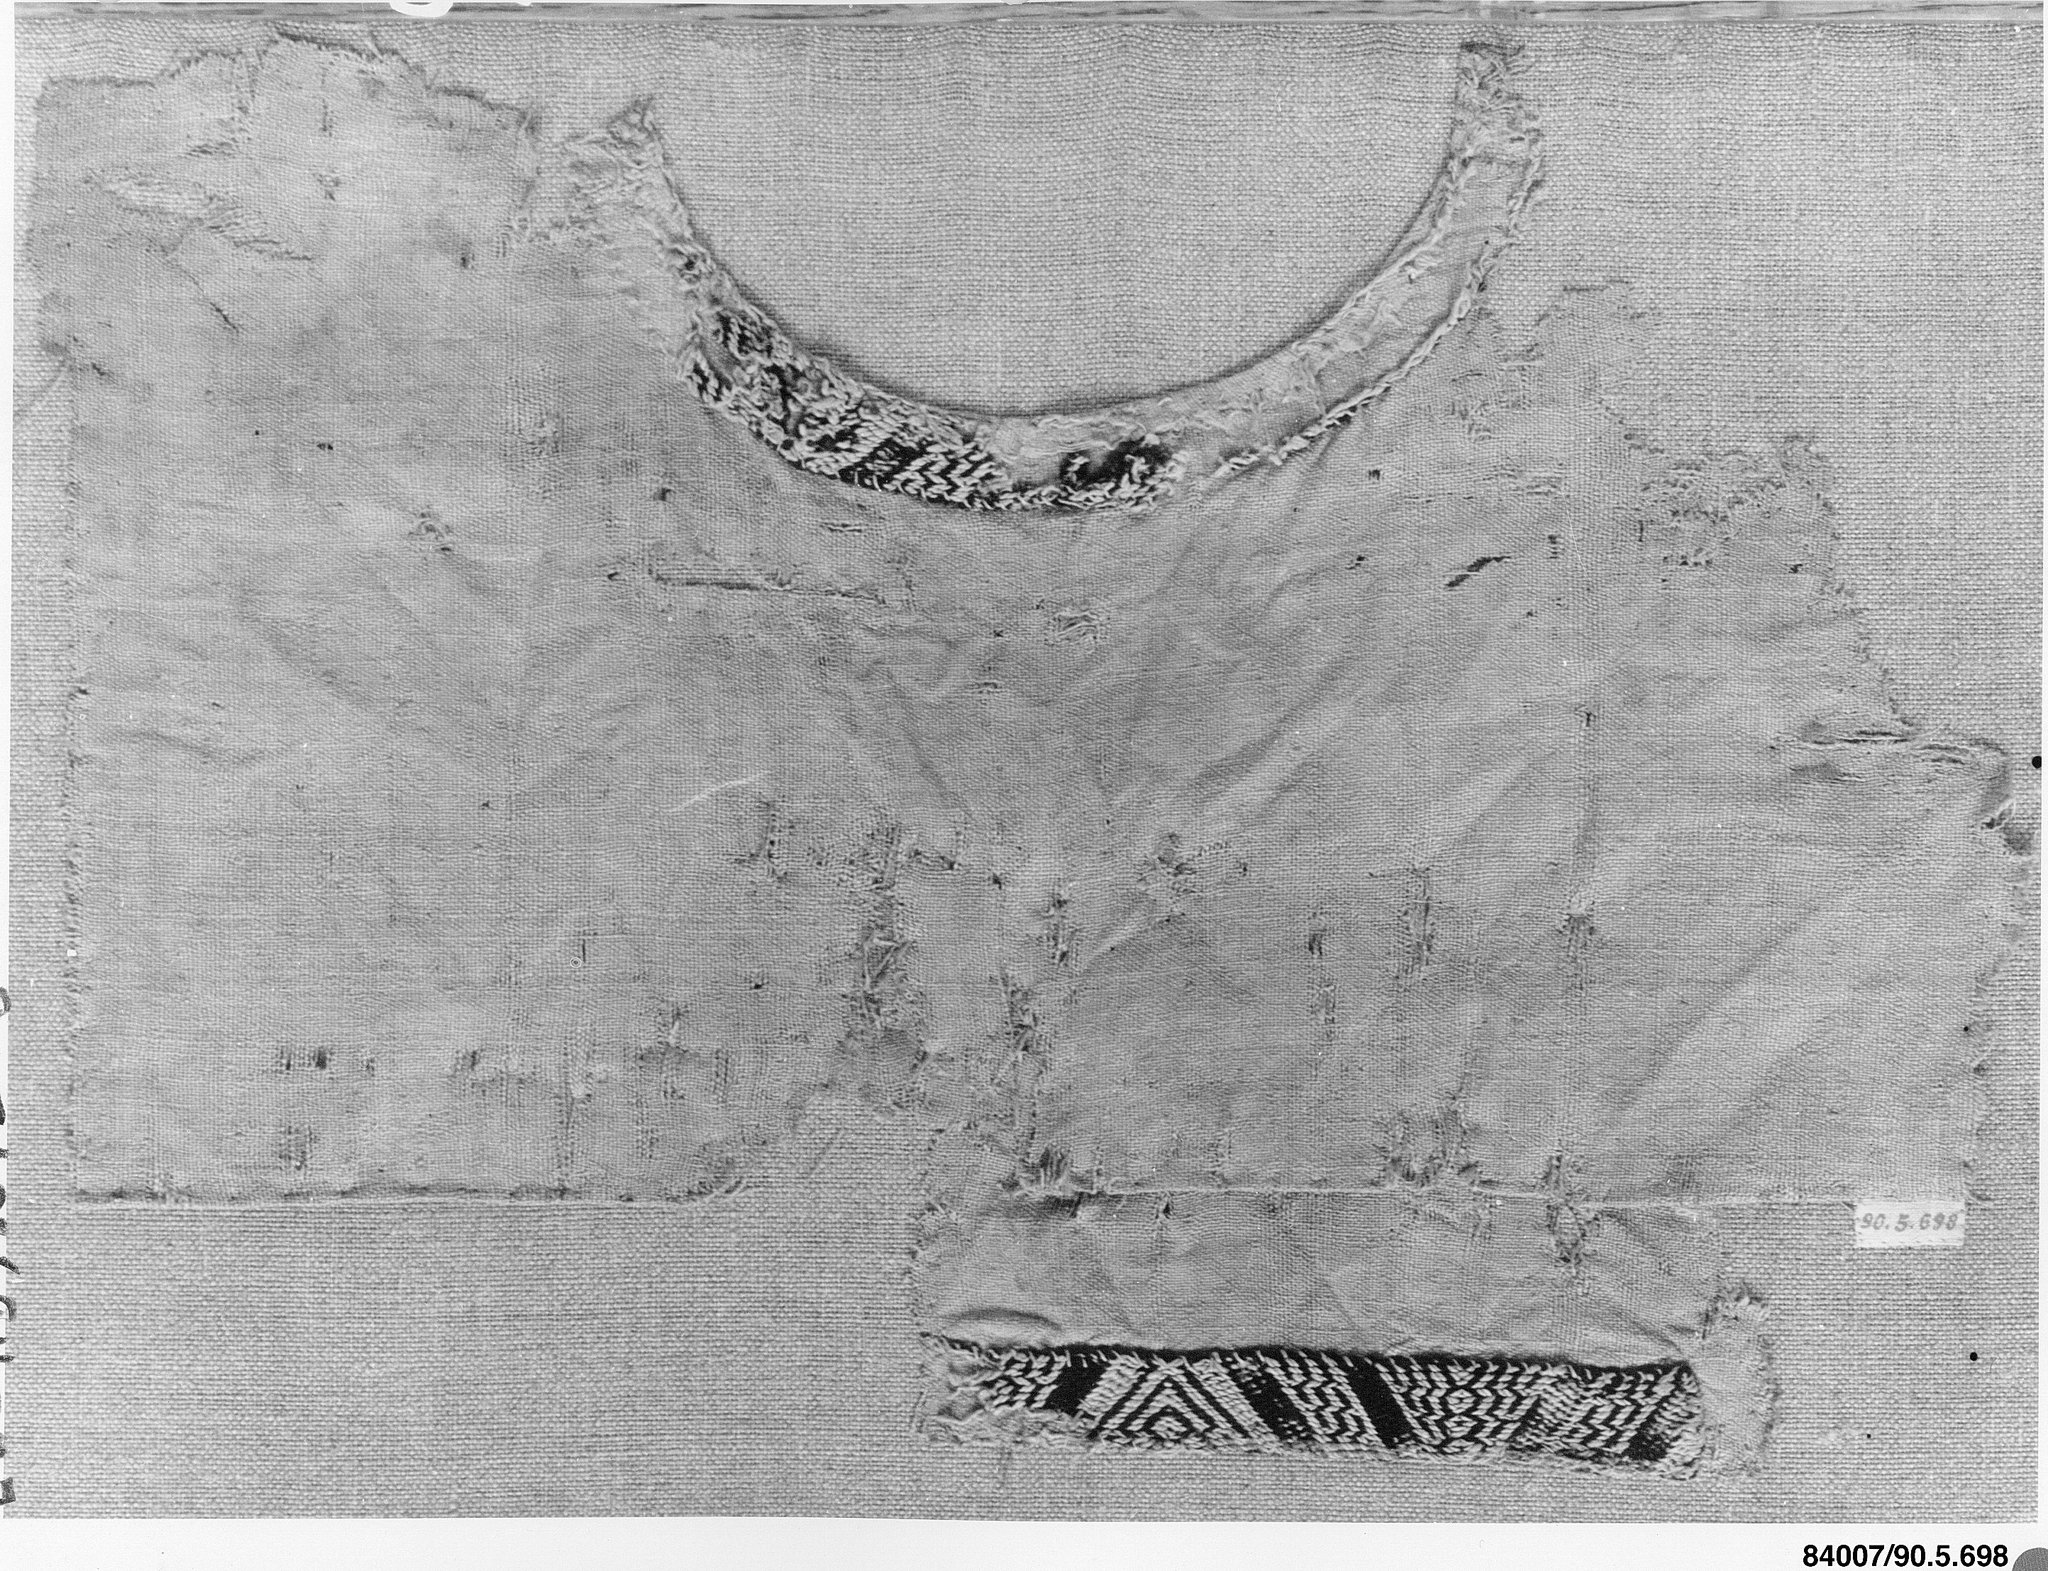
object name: tunic fragment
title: Fragment of a Tunic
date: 401-600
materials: linen, wool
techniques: weave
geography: egypt